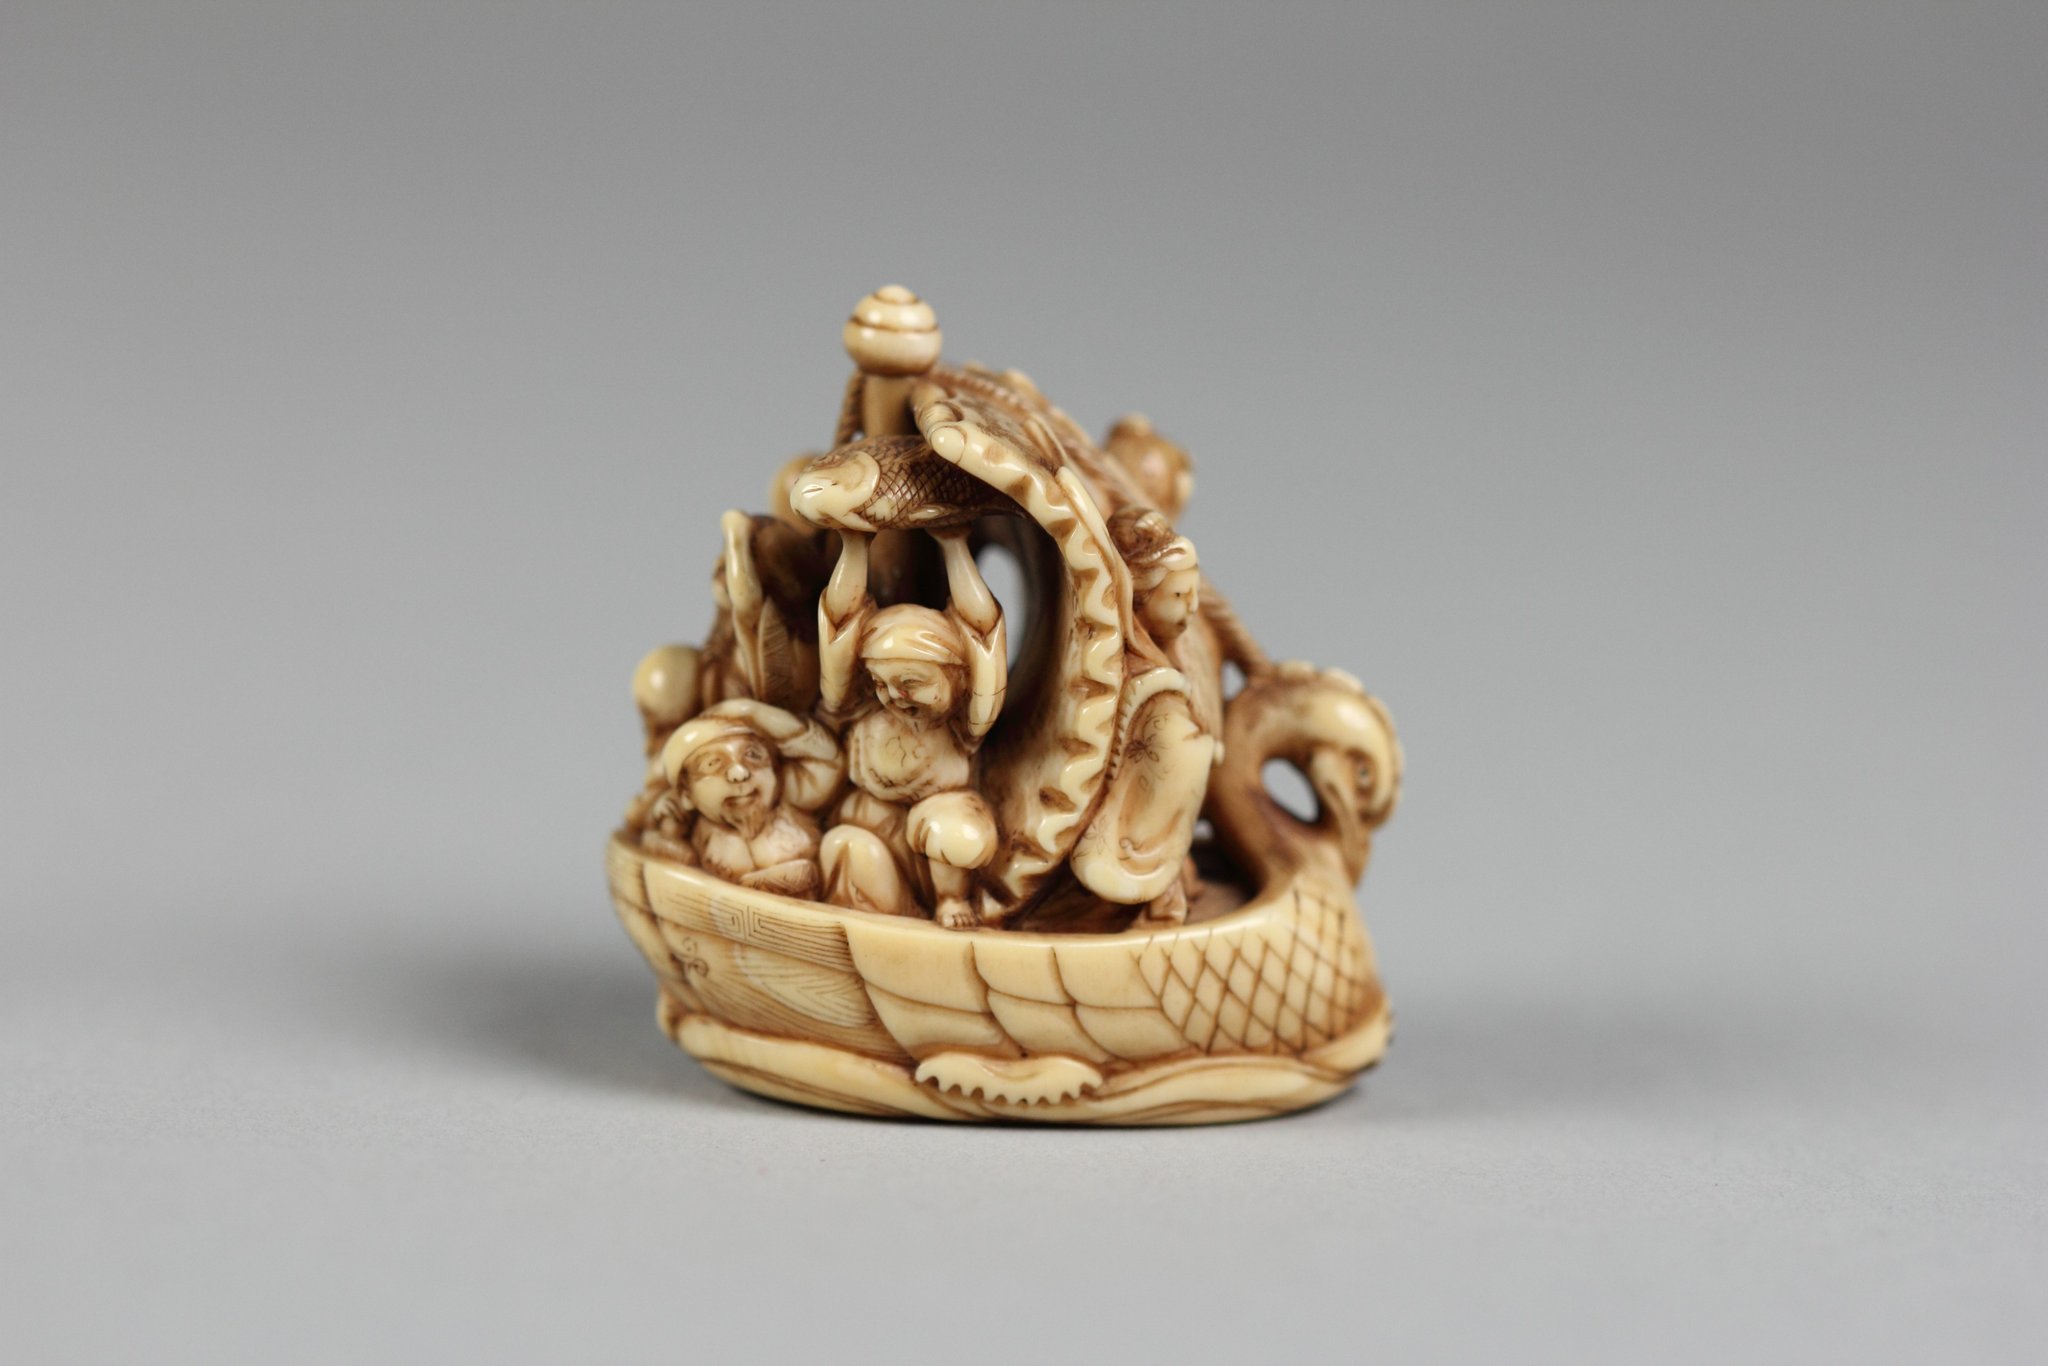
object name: netsuke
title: Netsuke of Pleasure Boat (Takarabune)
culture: japanese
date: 1801-1833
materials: ivory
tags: human figures,boats